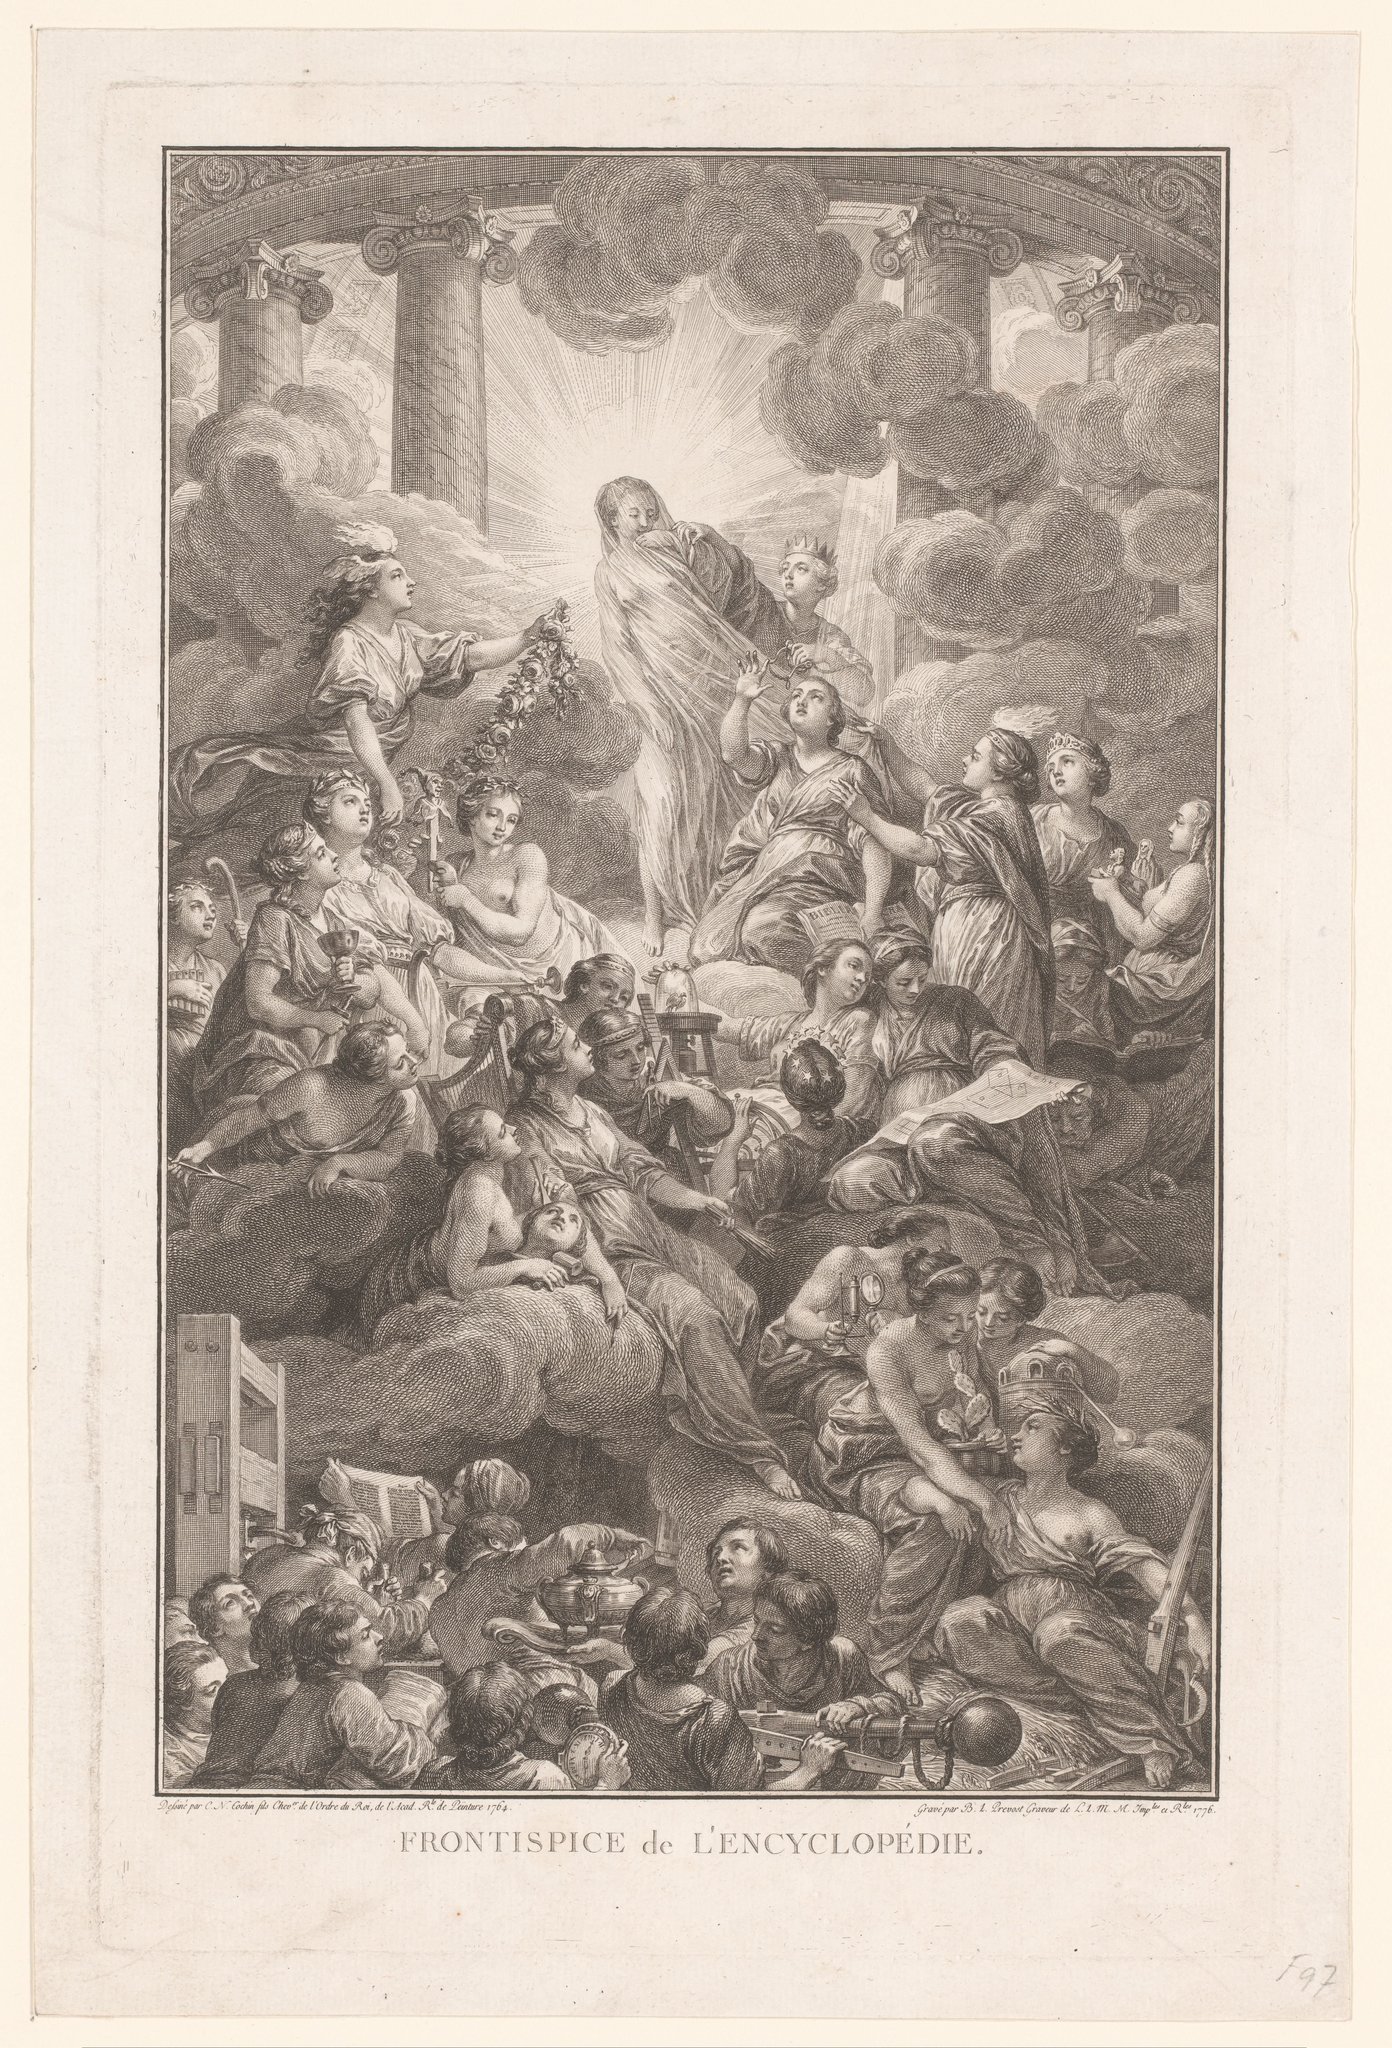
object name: titelblad, titelpagina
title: Waarheid schijnt haar licht over Rede, Filosofie en andere personificaties van kunsten en wetenschappen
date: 1751-1776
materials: paper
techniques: engraving, etching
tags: symbolic representations, allegories and emblems ~ science, 'scientia'; 'scienza', 'studio' (ripa), printing press, 'philosophia'; 'filosofia' (ripa), reason; 'ragione' (ripa), single muses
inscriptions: collector's mark: Lugt 2760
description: Titelpagina voor: Diderot, Denis en Jean Le Rond d’Alembert. Encyclopédie ou dictionnaire raisonné des sciences, des arts et des métiers. Parijs : Antoine-Claude Briasson et al, 1751-1772.